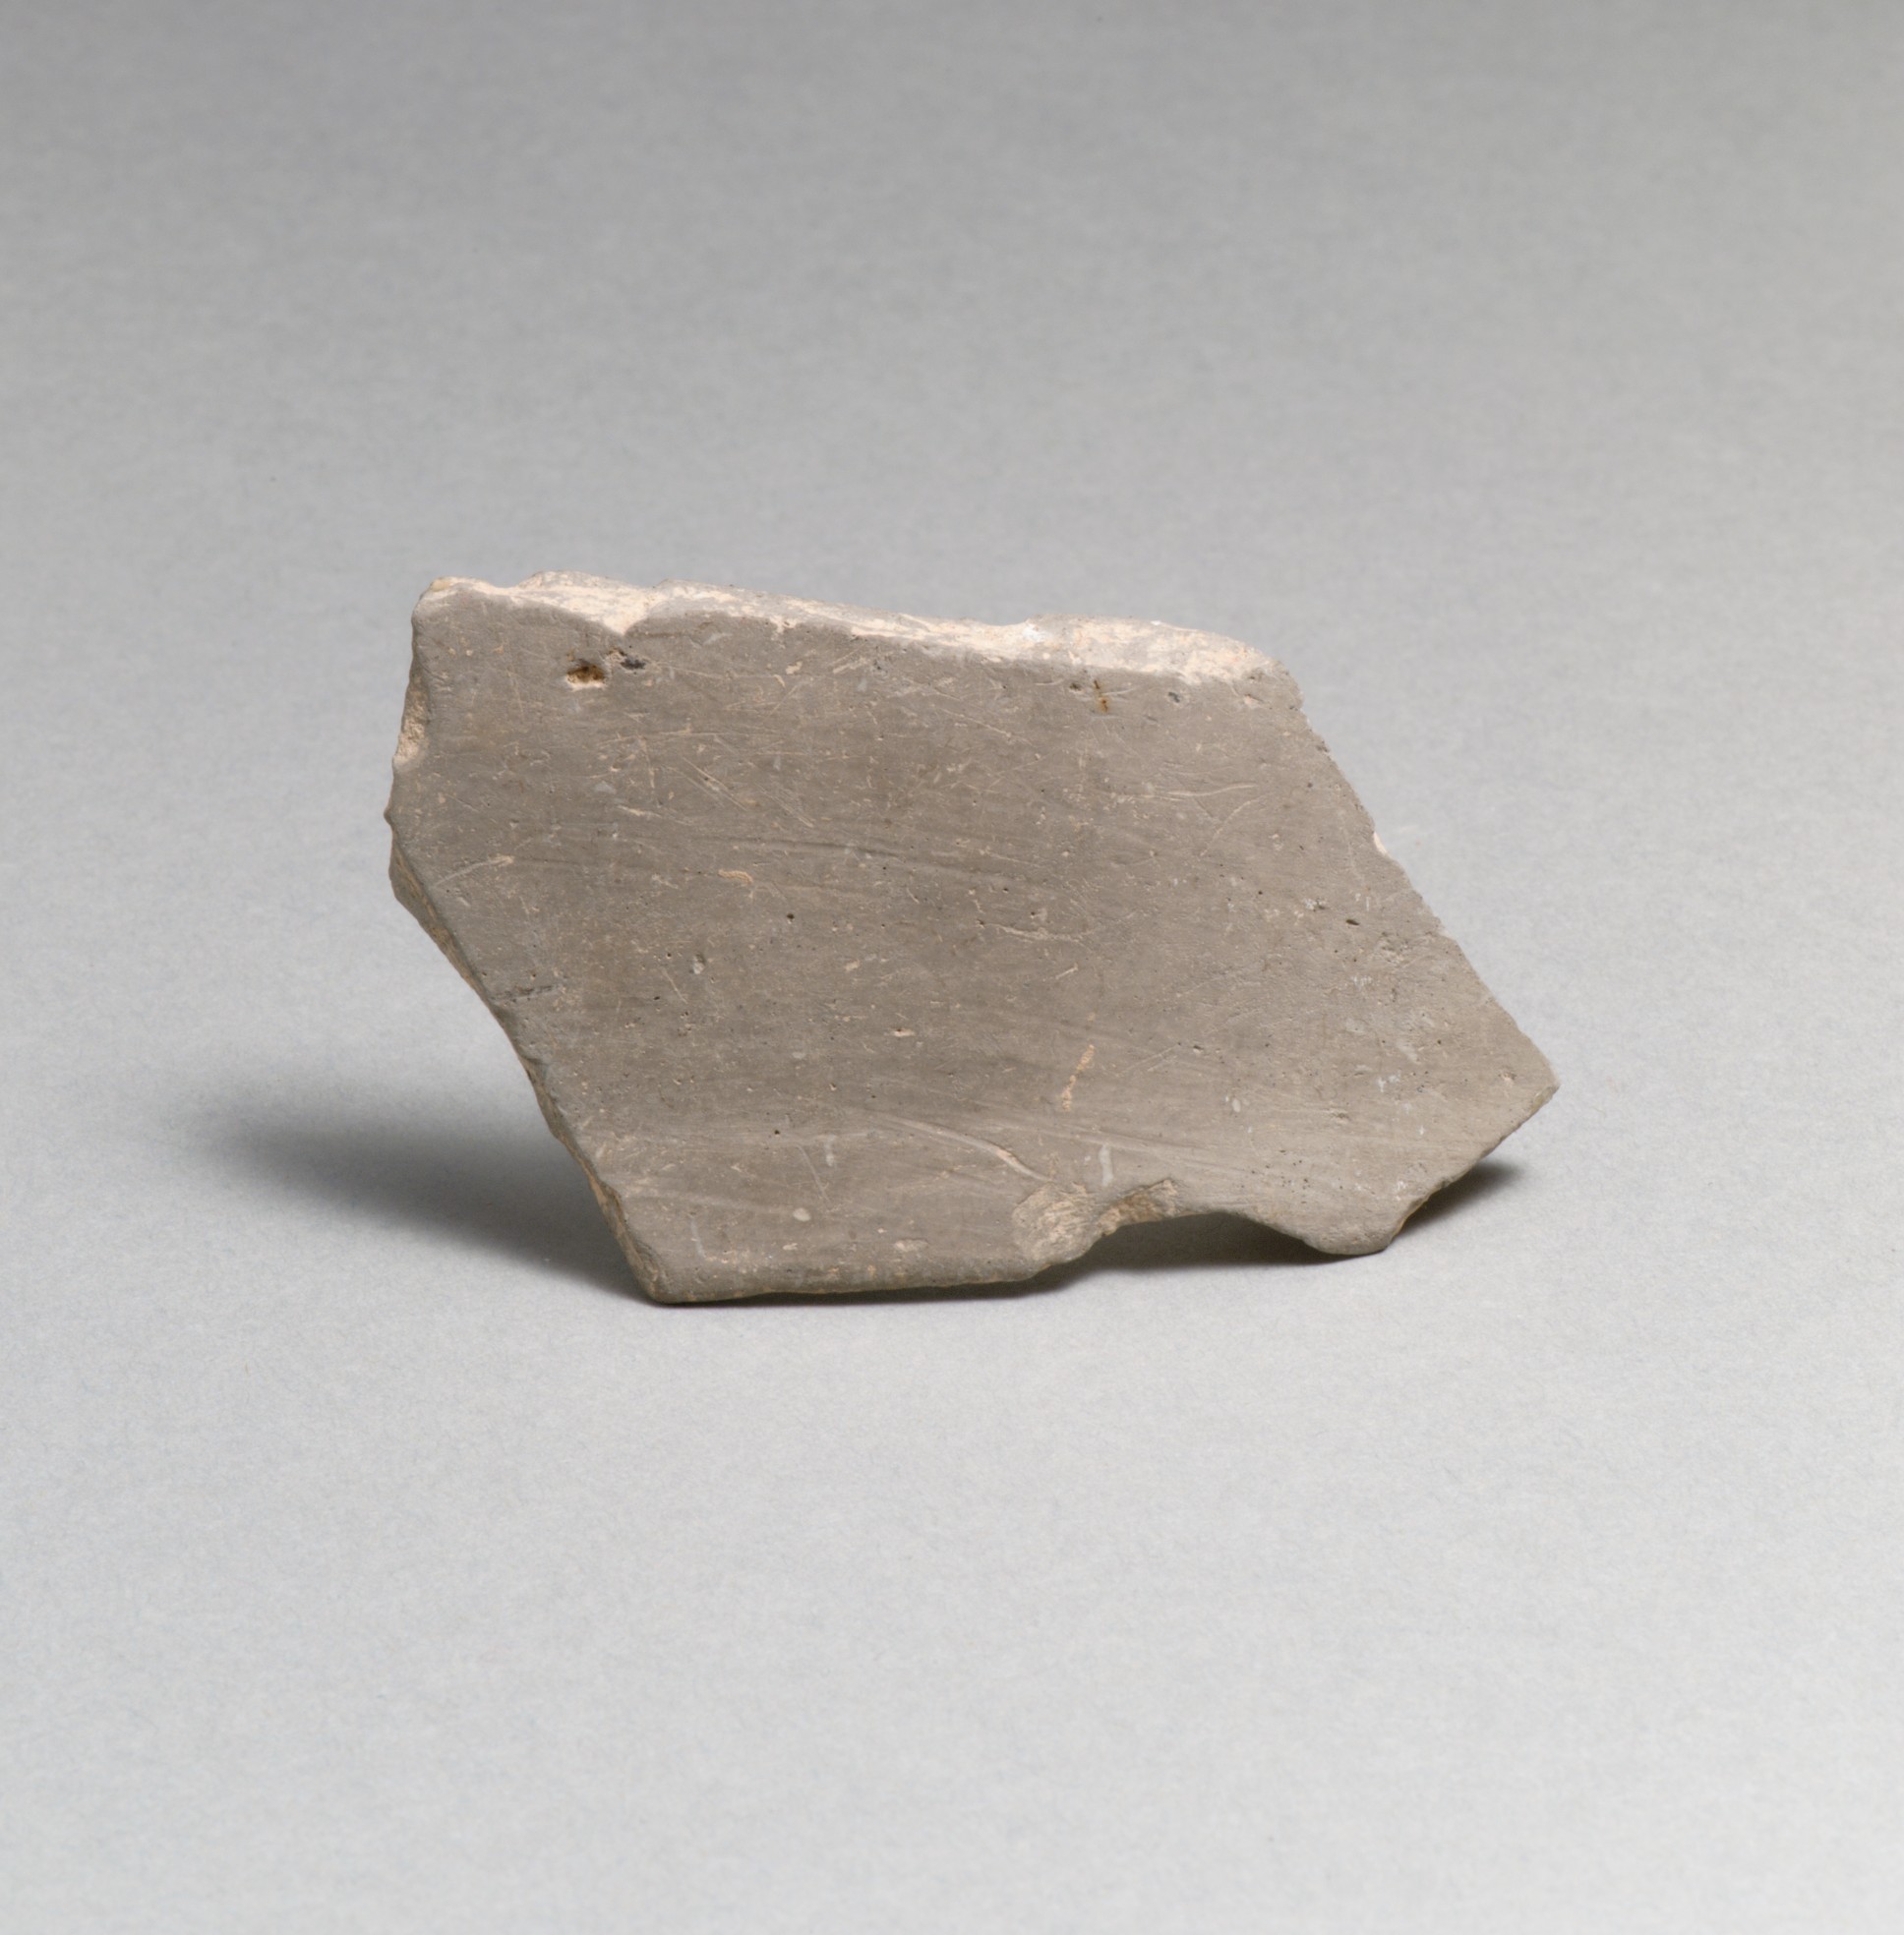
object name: vase fragment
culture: minoan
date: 2600-2000 BCE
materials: terracotta